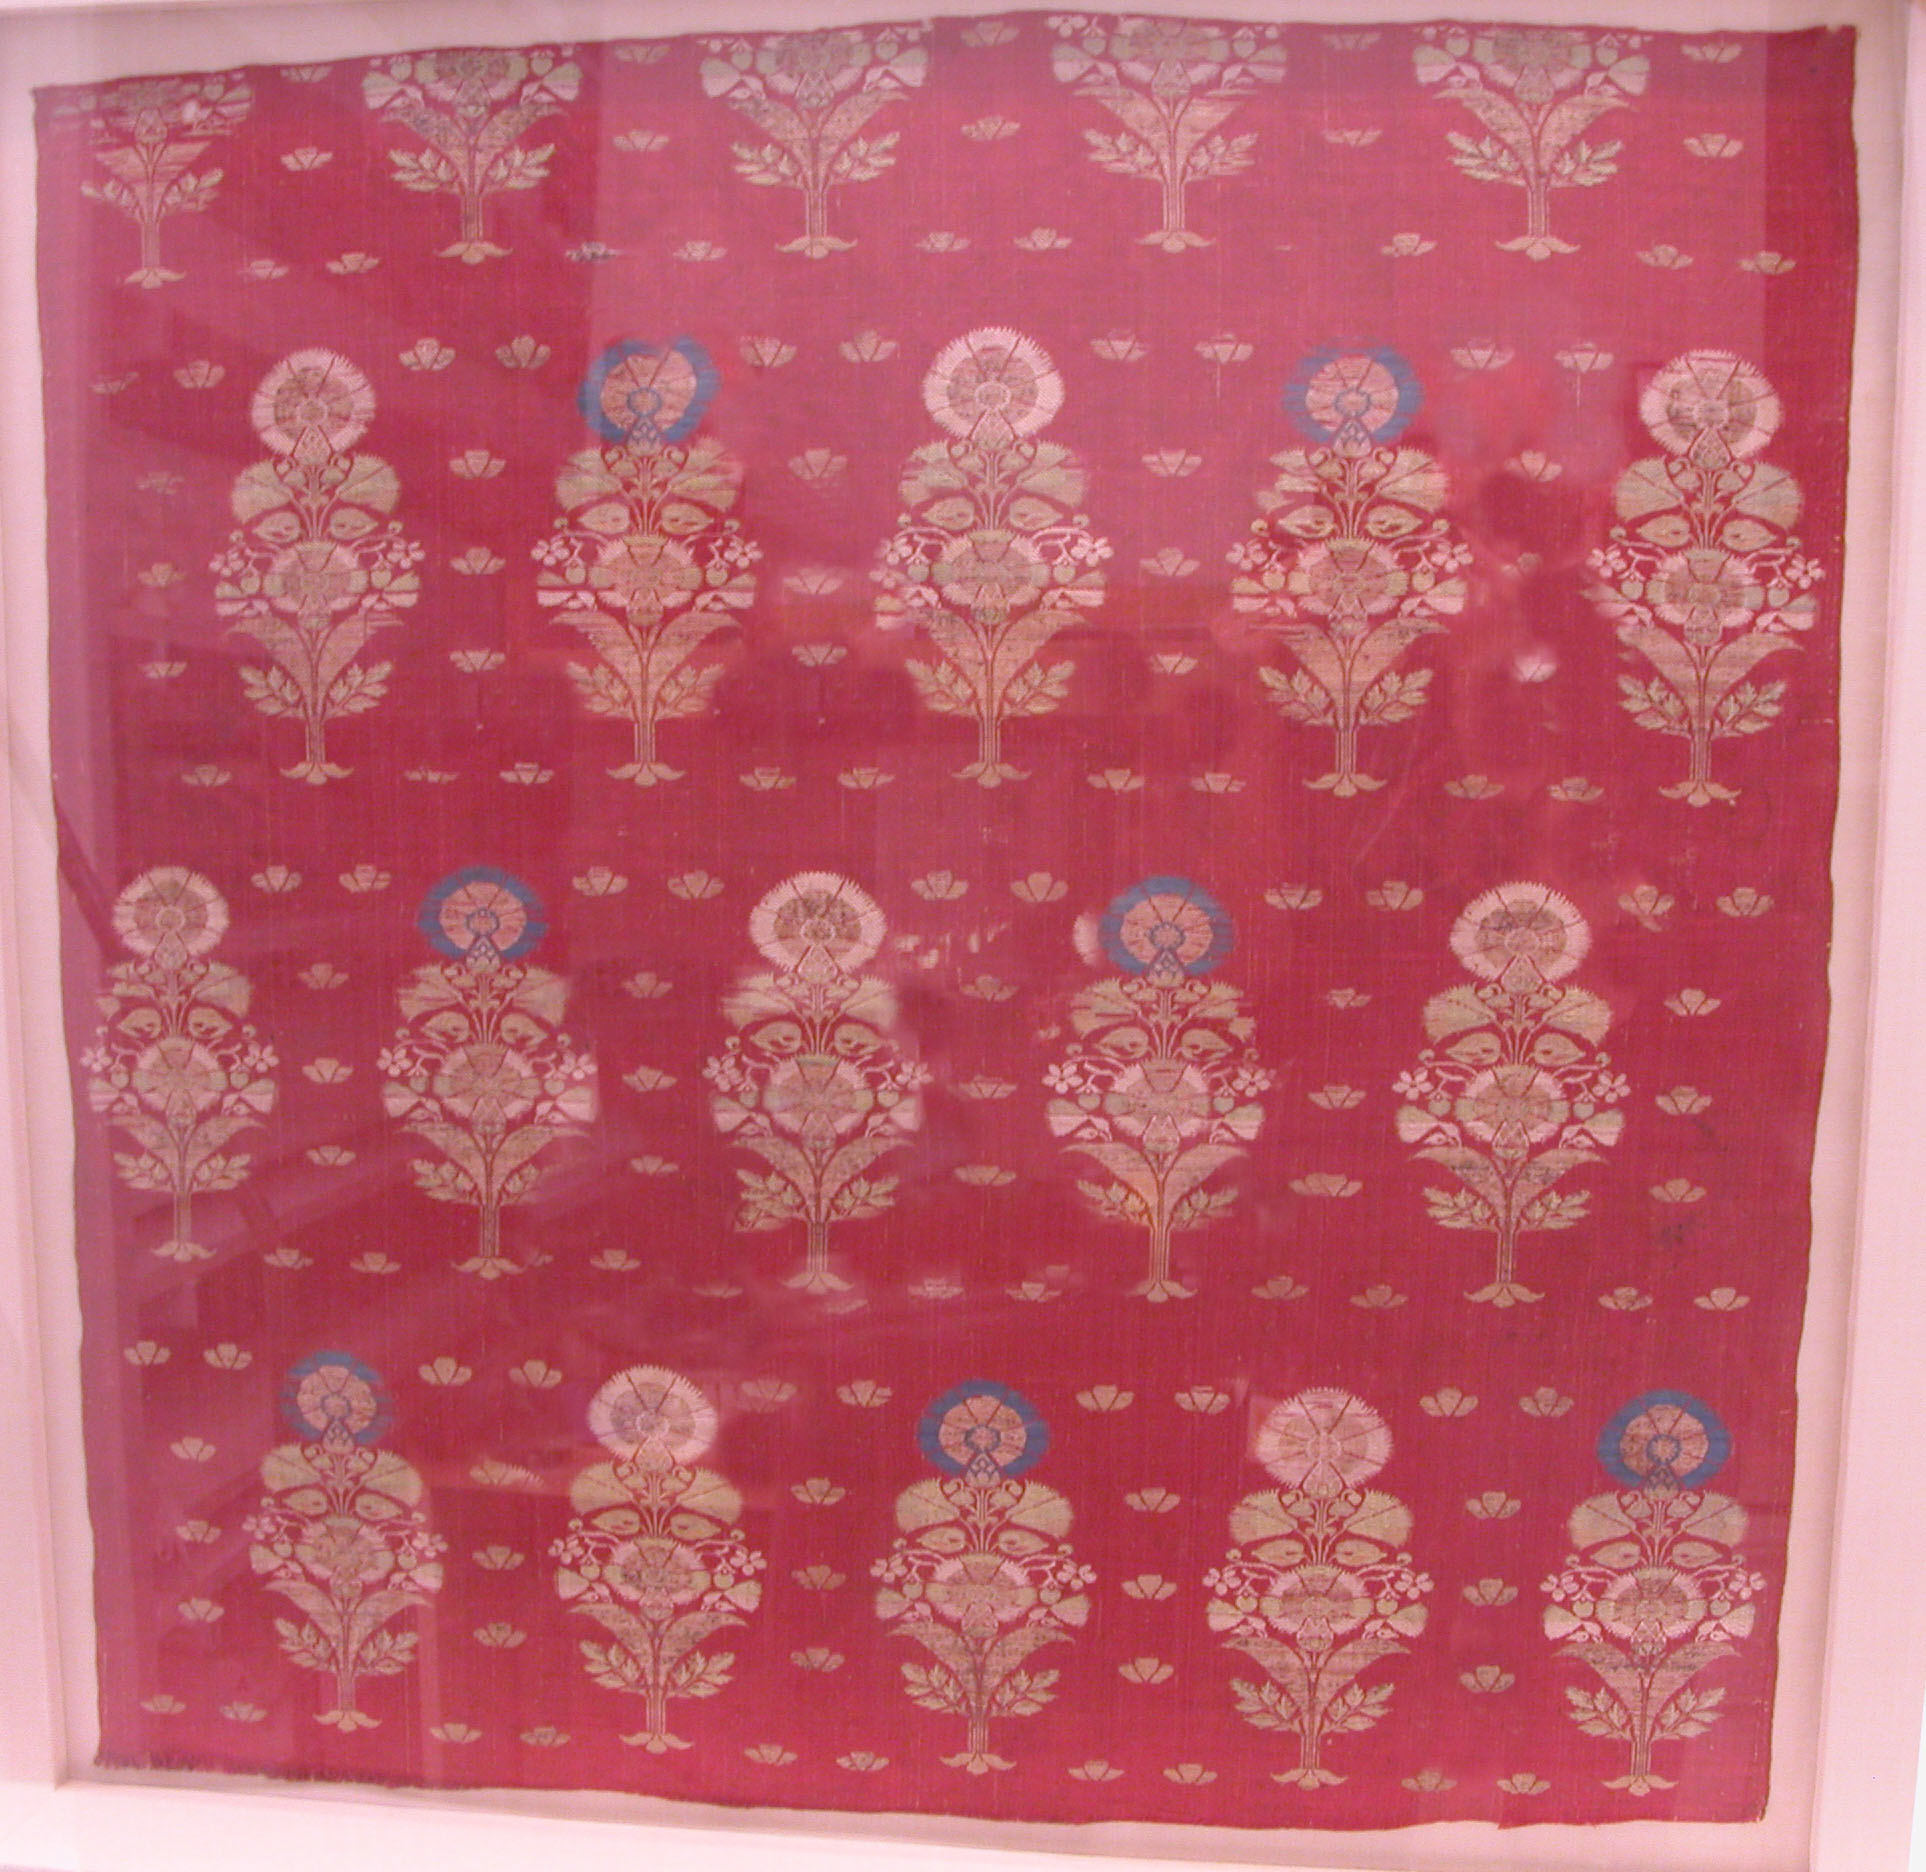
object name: textile fragment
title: Floral Brocade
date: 1667-1733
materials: metal thread, silk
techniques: lampas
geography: iran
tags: flowers